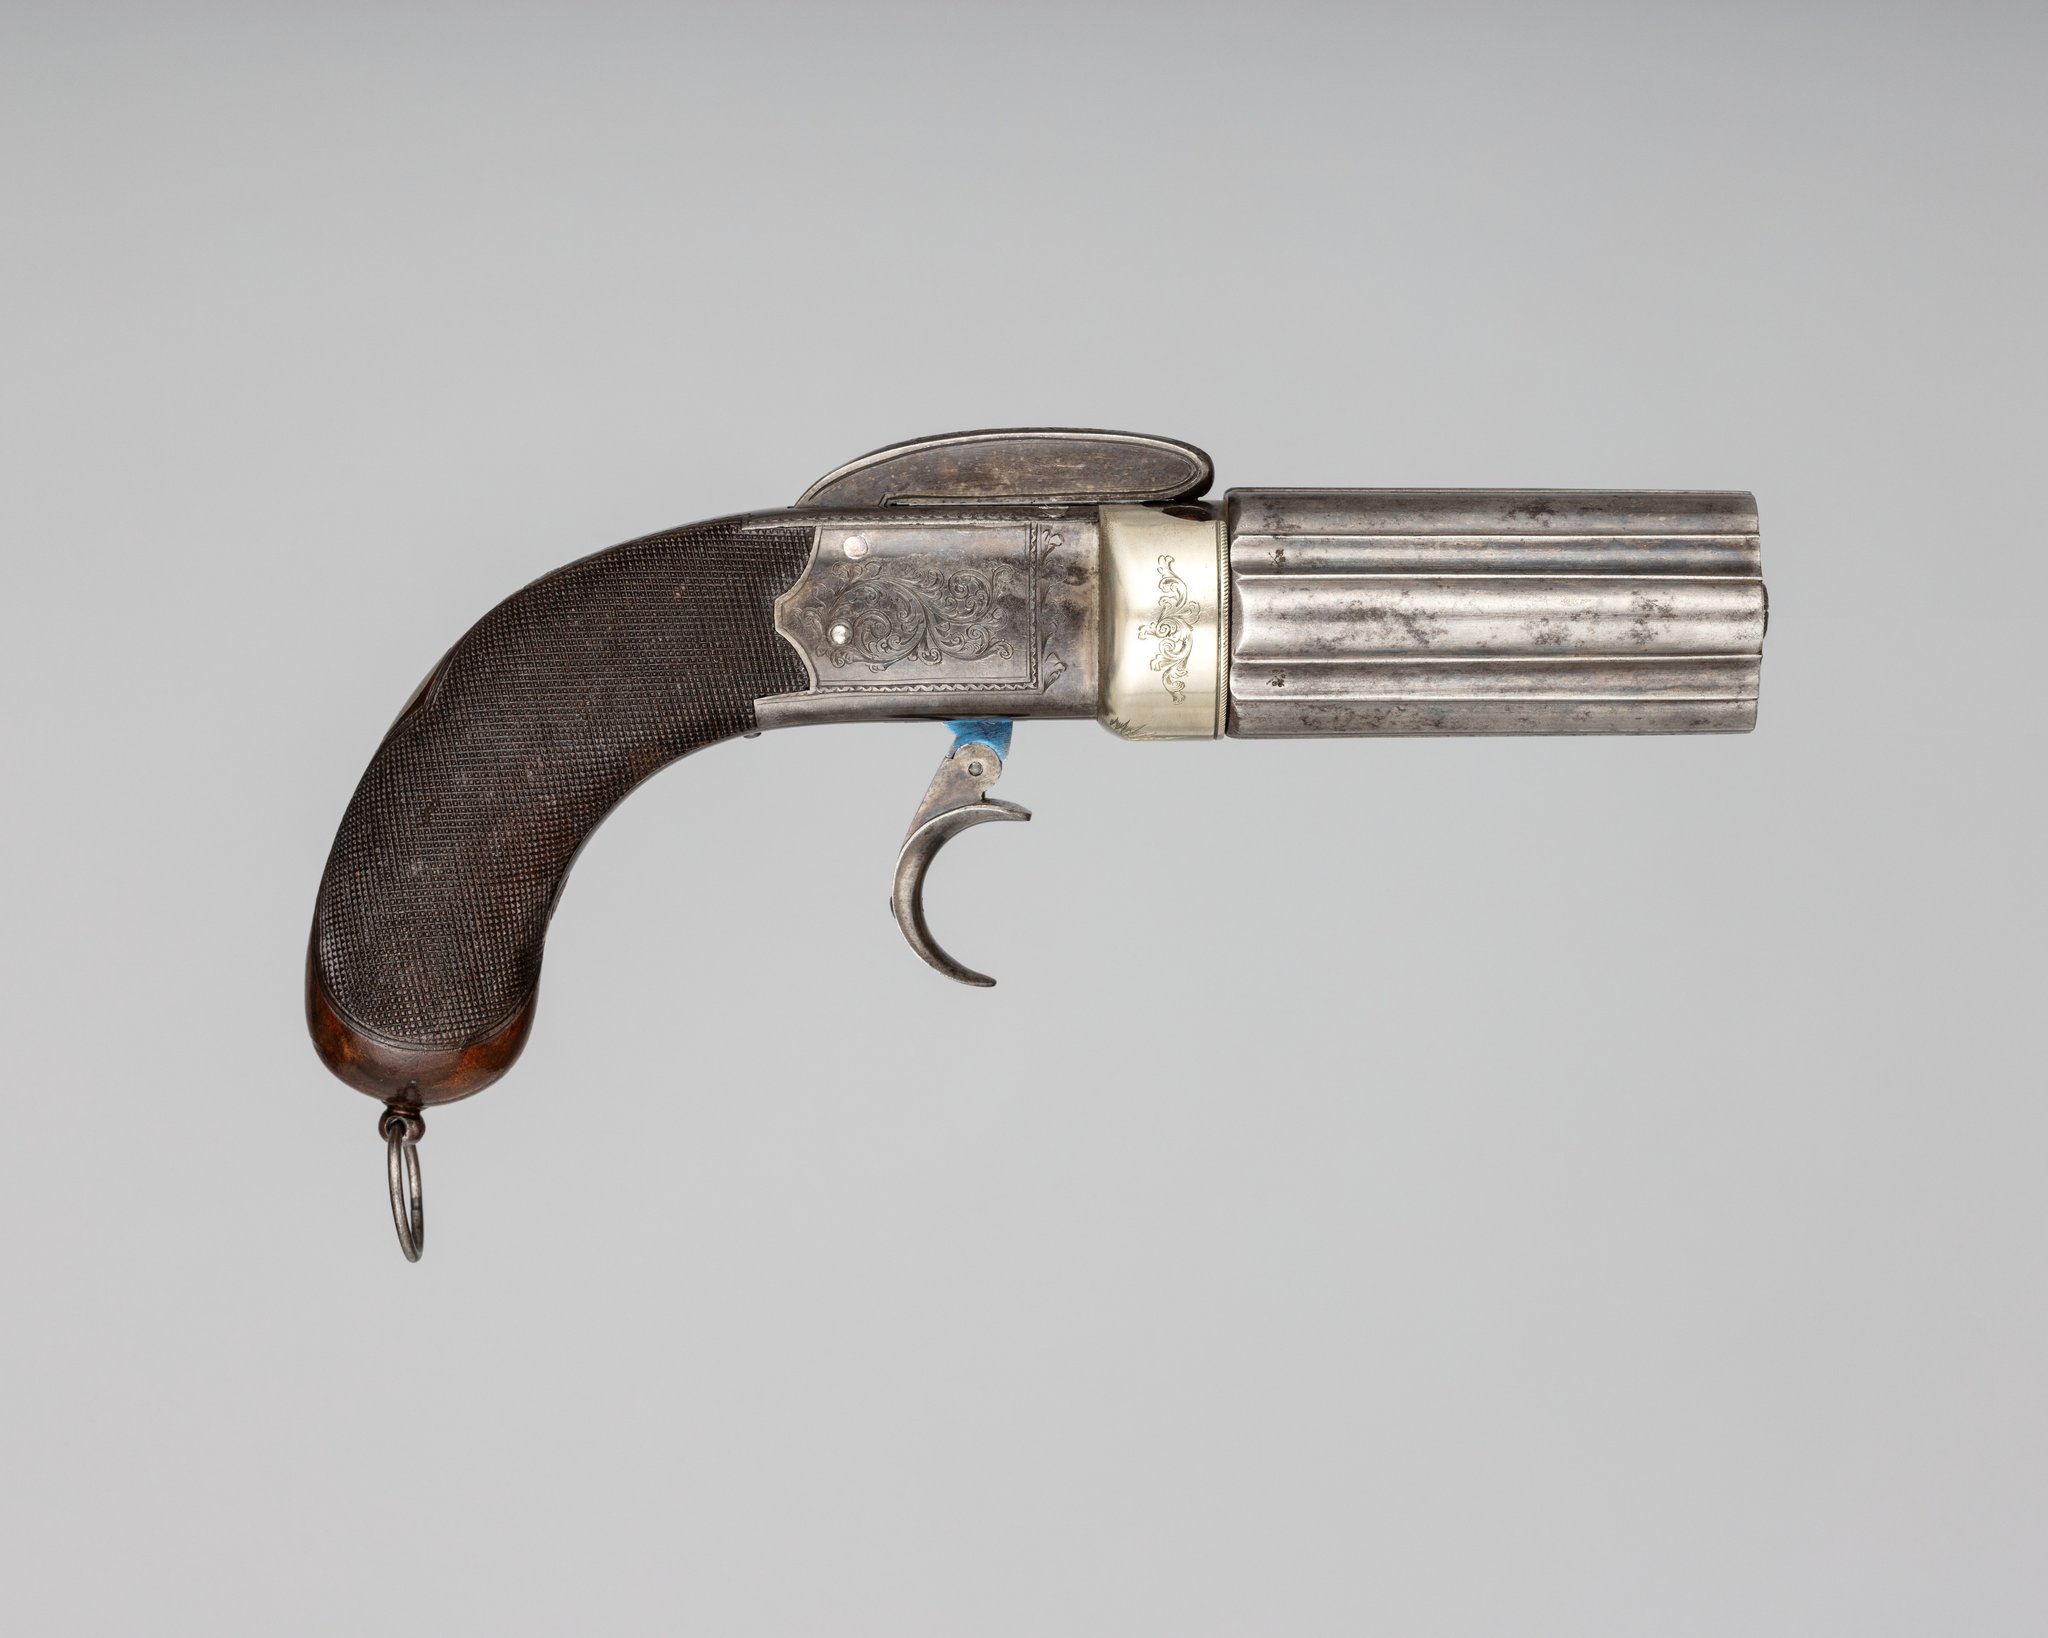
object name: six shot pepperbox detonator pistol with case and accessory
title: Six-Barreled Pepperbox Disk Primer Pistol with Case and Accessories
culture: british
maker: joseph rock cooper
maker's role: gunsmith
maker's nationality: british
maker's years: 1814-1882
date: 1840-1850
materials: brass, copper, gold, lacquer, silver, steel, textile, tin, wood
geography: england